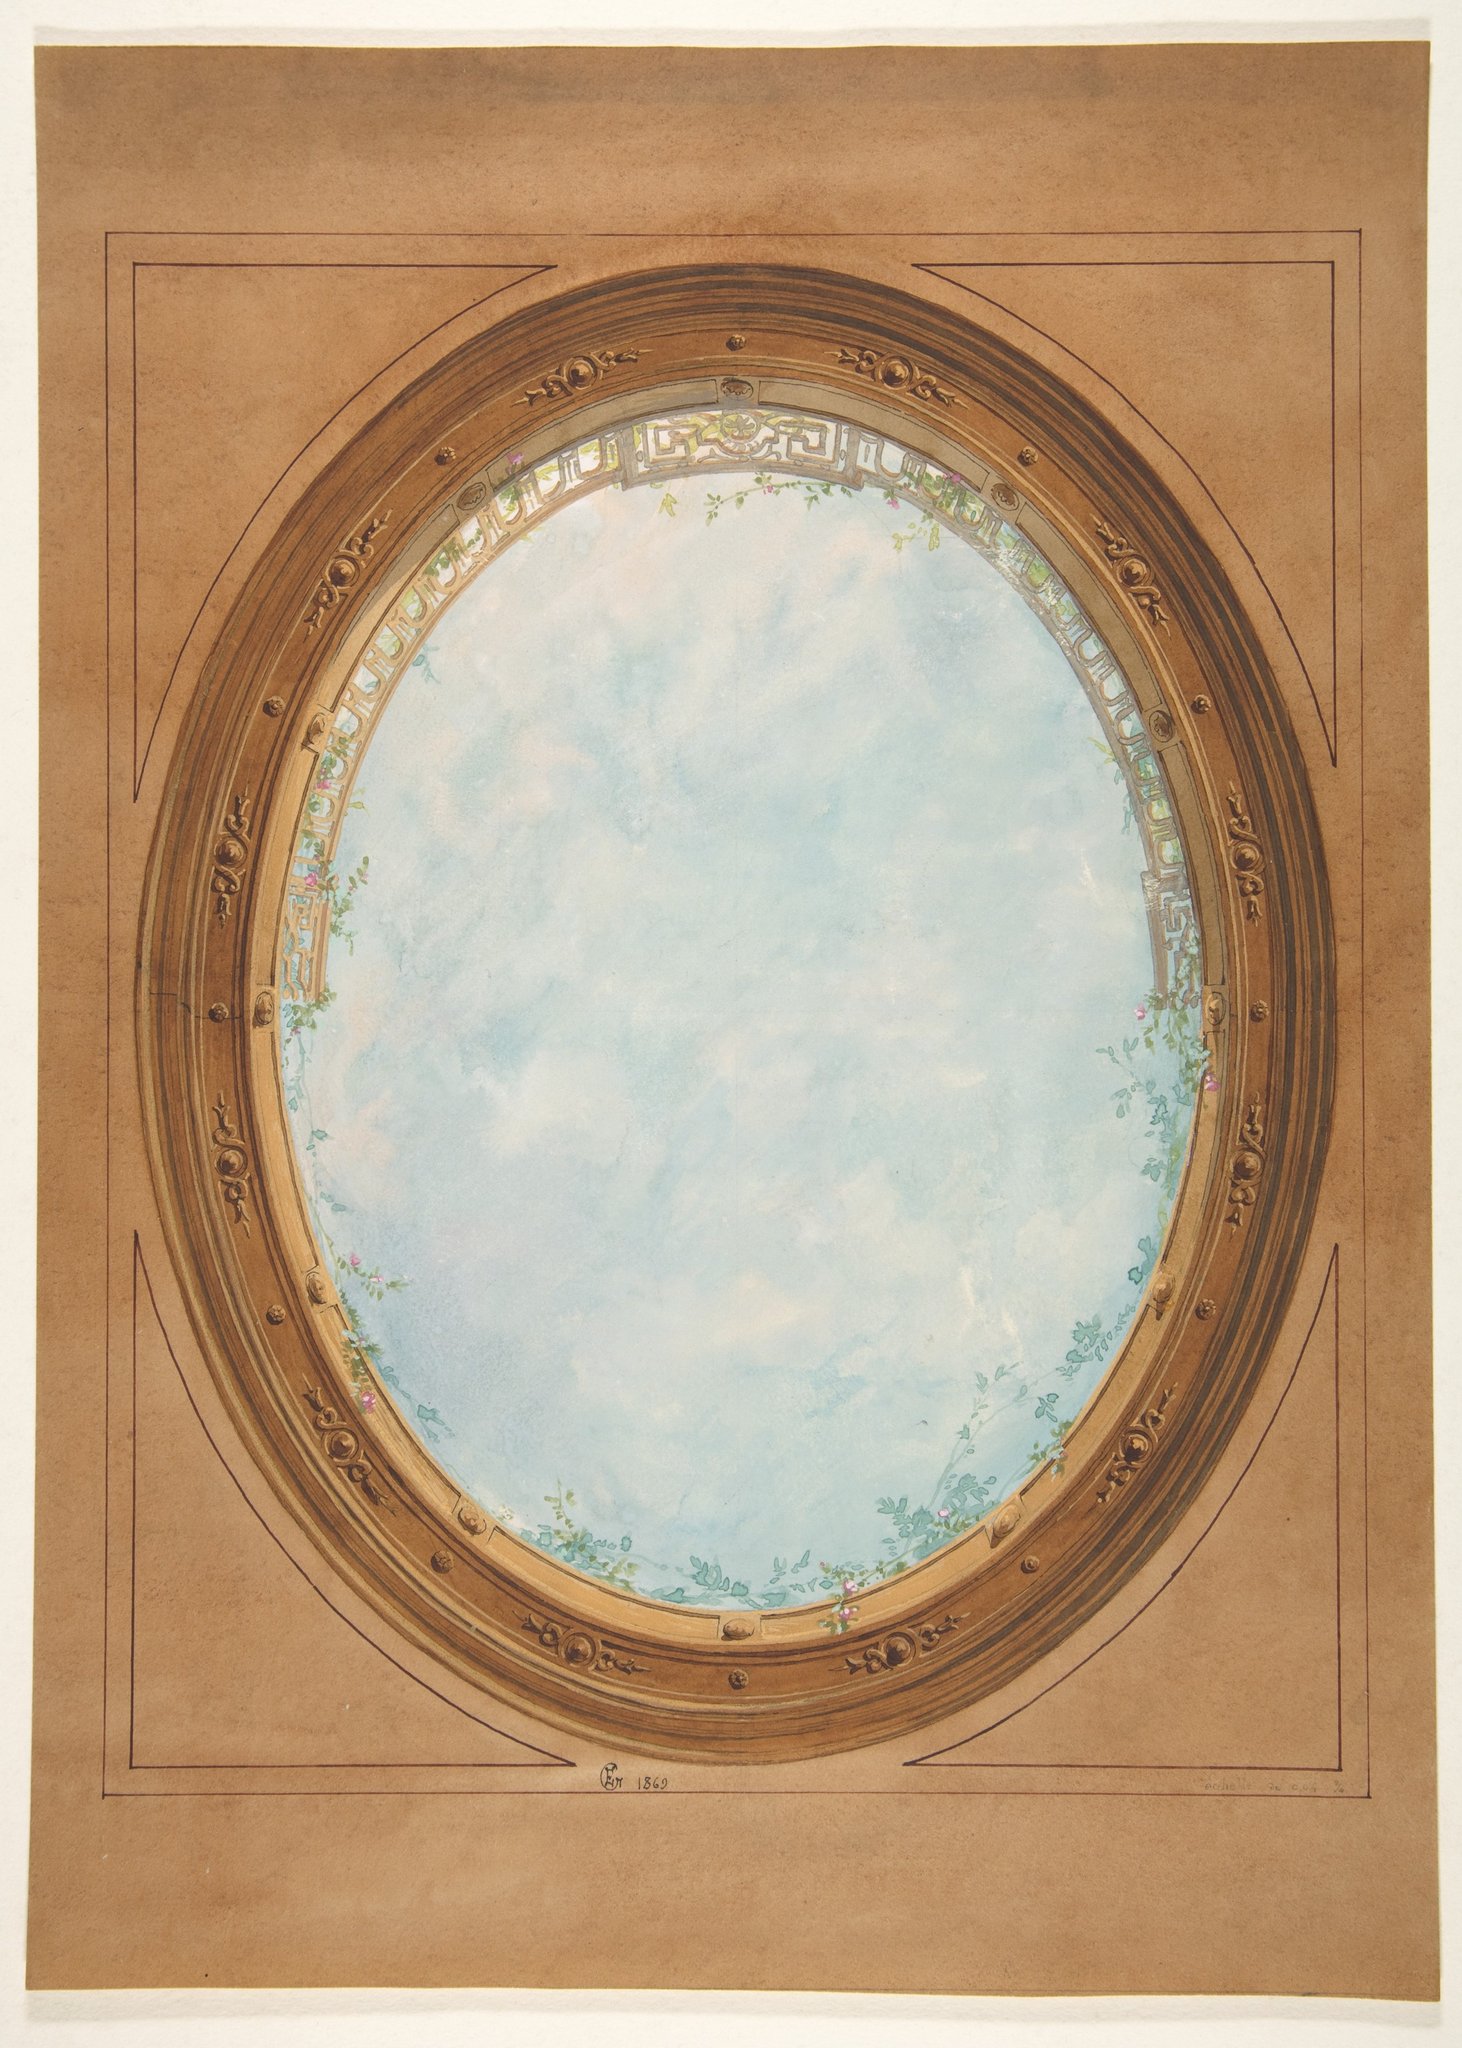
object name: drawing ornament architecture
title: Design for a ceiling with trompe l'oeil balustrade and sky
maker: jules-edmond-charles lachaise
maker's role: artist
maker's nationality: french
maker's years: 1897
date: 1869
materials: graphite, ink, watercolor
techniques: pen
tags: architecture,sky